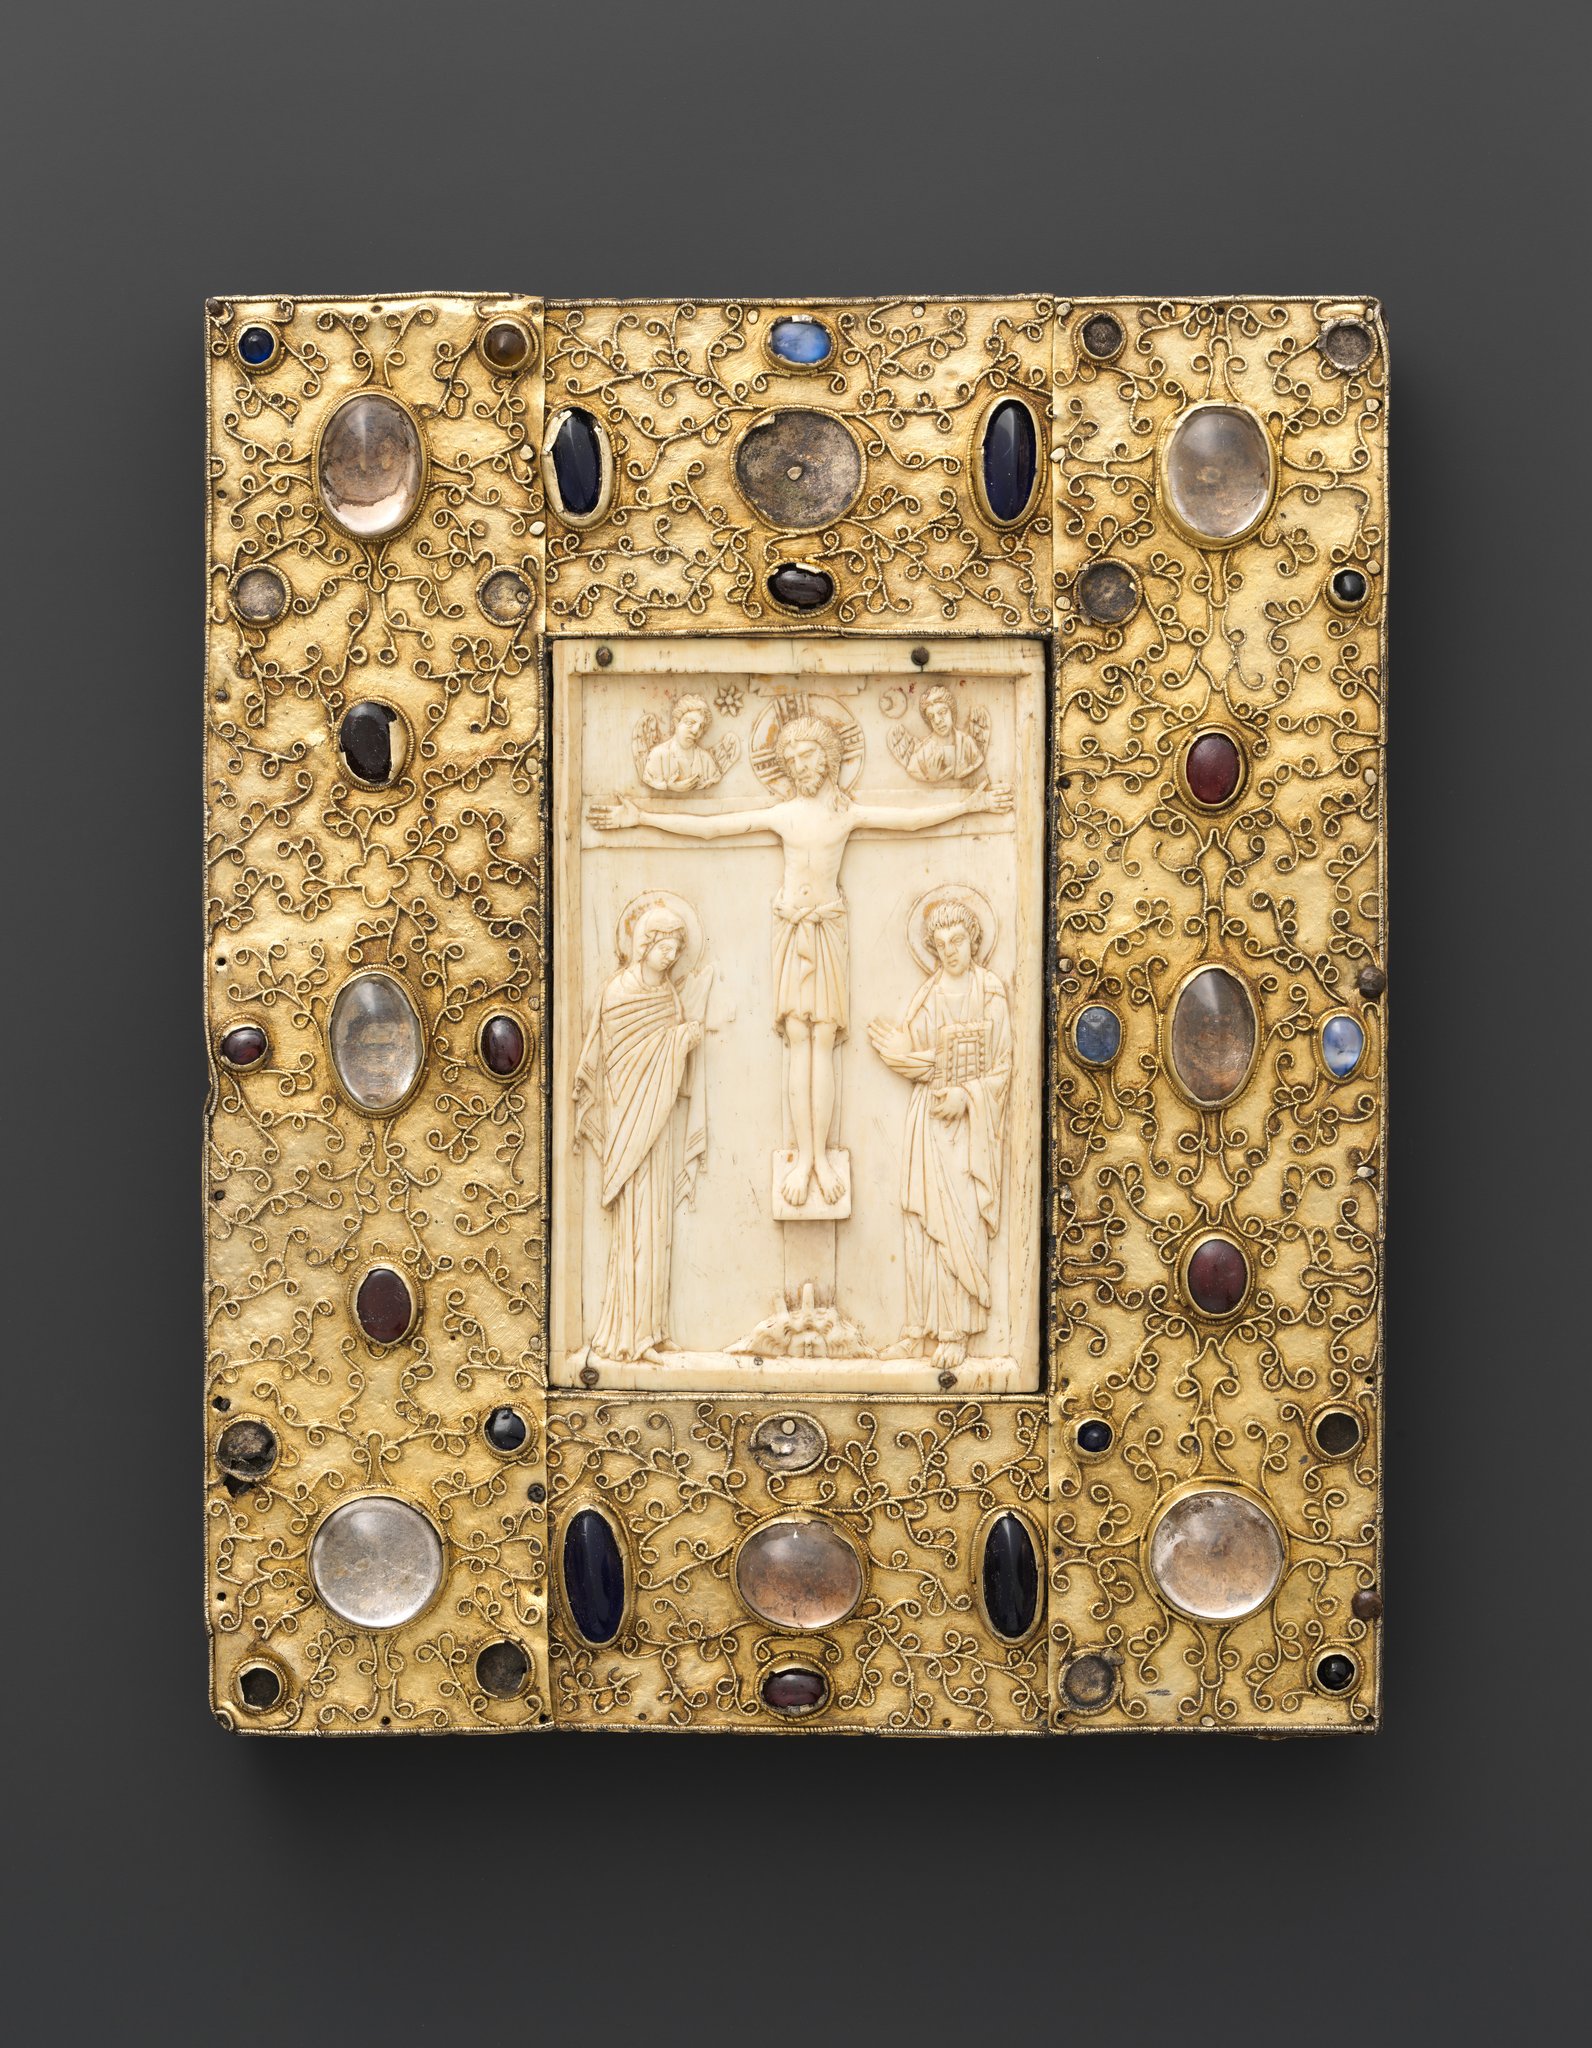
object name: panel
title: Panel with Byzantine Ivory Carving of the Crucifixion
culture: byzantine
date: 901-1000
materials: crystal, glass, ivory, gemstone, silver gilt, wood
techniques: filigree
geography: constantinople (ivory)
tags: christ,virgin mary,crucifixion,saint john